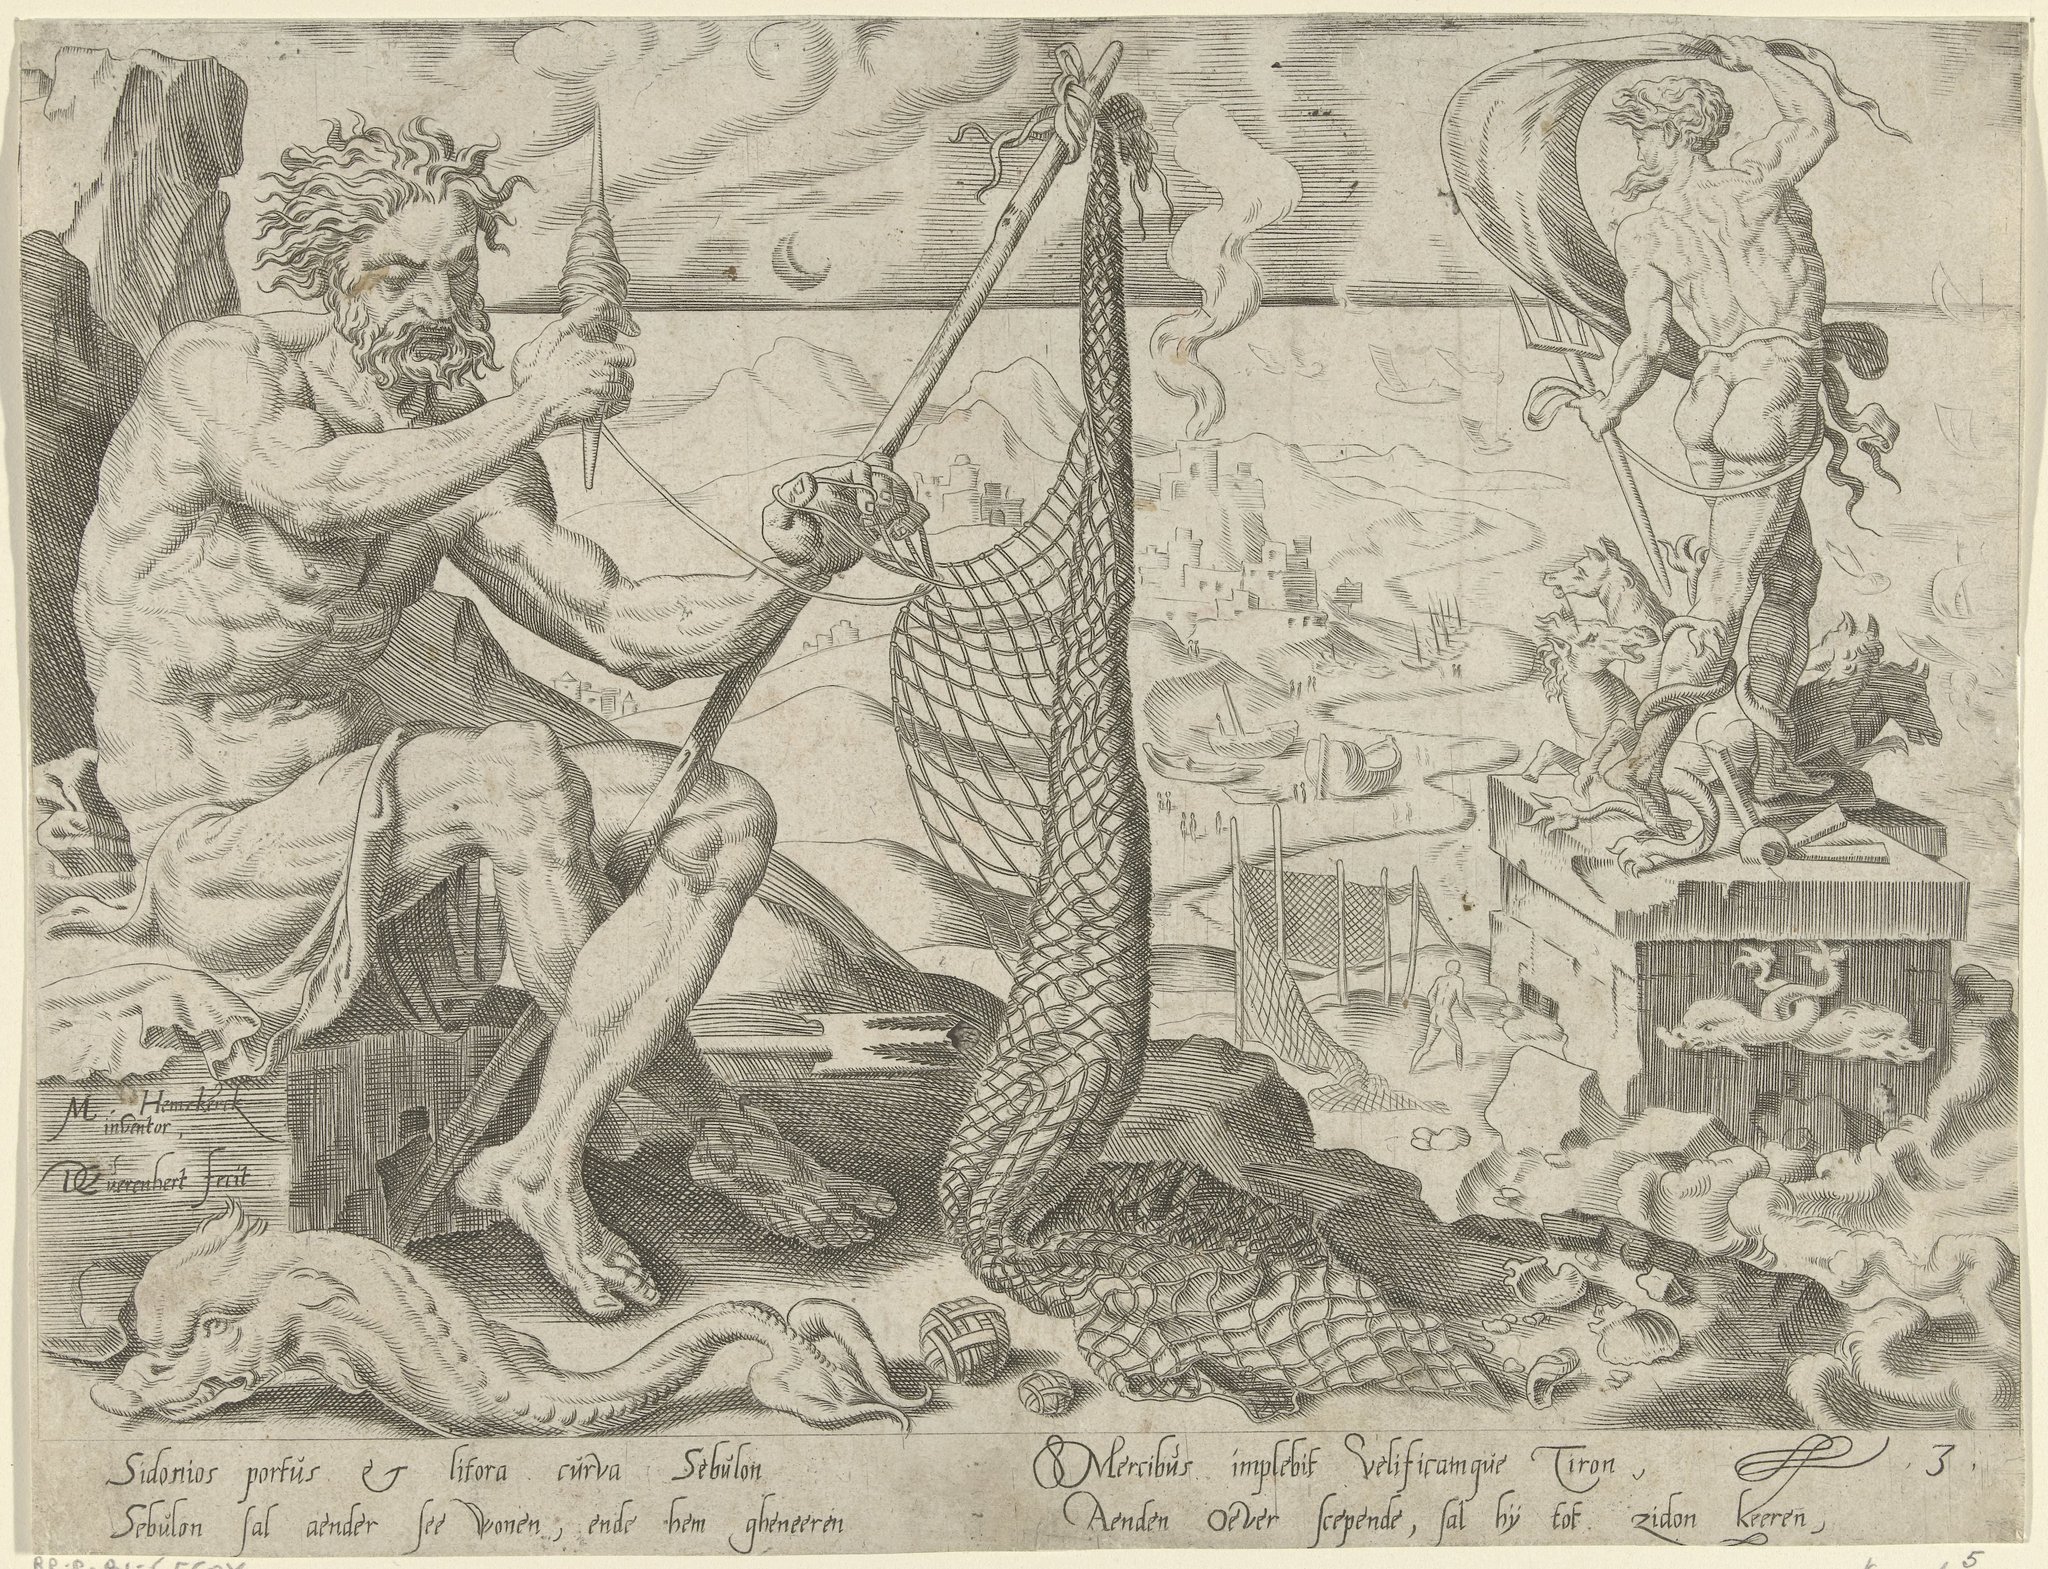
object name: print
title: Twaalf zonen van Jakob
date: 1550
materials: paper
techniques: engraving, etching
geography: haarlem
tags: (story of) neptune (poseidon), jacob blesses his sons, swimming mammals: dolphin (+ animals used symbolically), male persons from the old testament (with name) (not in biblical context)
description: Zebulon, de tiende zoon van Jakob. Zebulon is gekleed als een visser en maakt een visnet. Naast hem ligt een dolfijn. In de achtergrond het standbeeld van Neptunus. Alle attributen refereren naar Jakobs zegening van Zebulon (Genesis 49). De prent maakt deel uit van een serie over de twaalf zonen van Jakob en patriarchen van Israël en heeft een Nederlands en Latijns onderschrift.